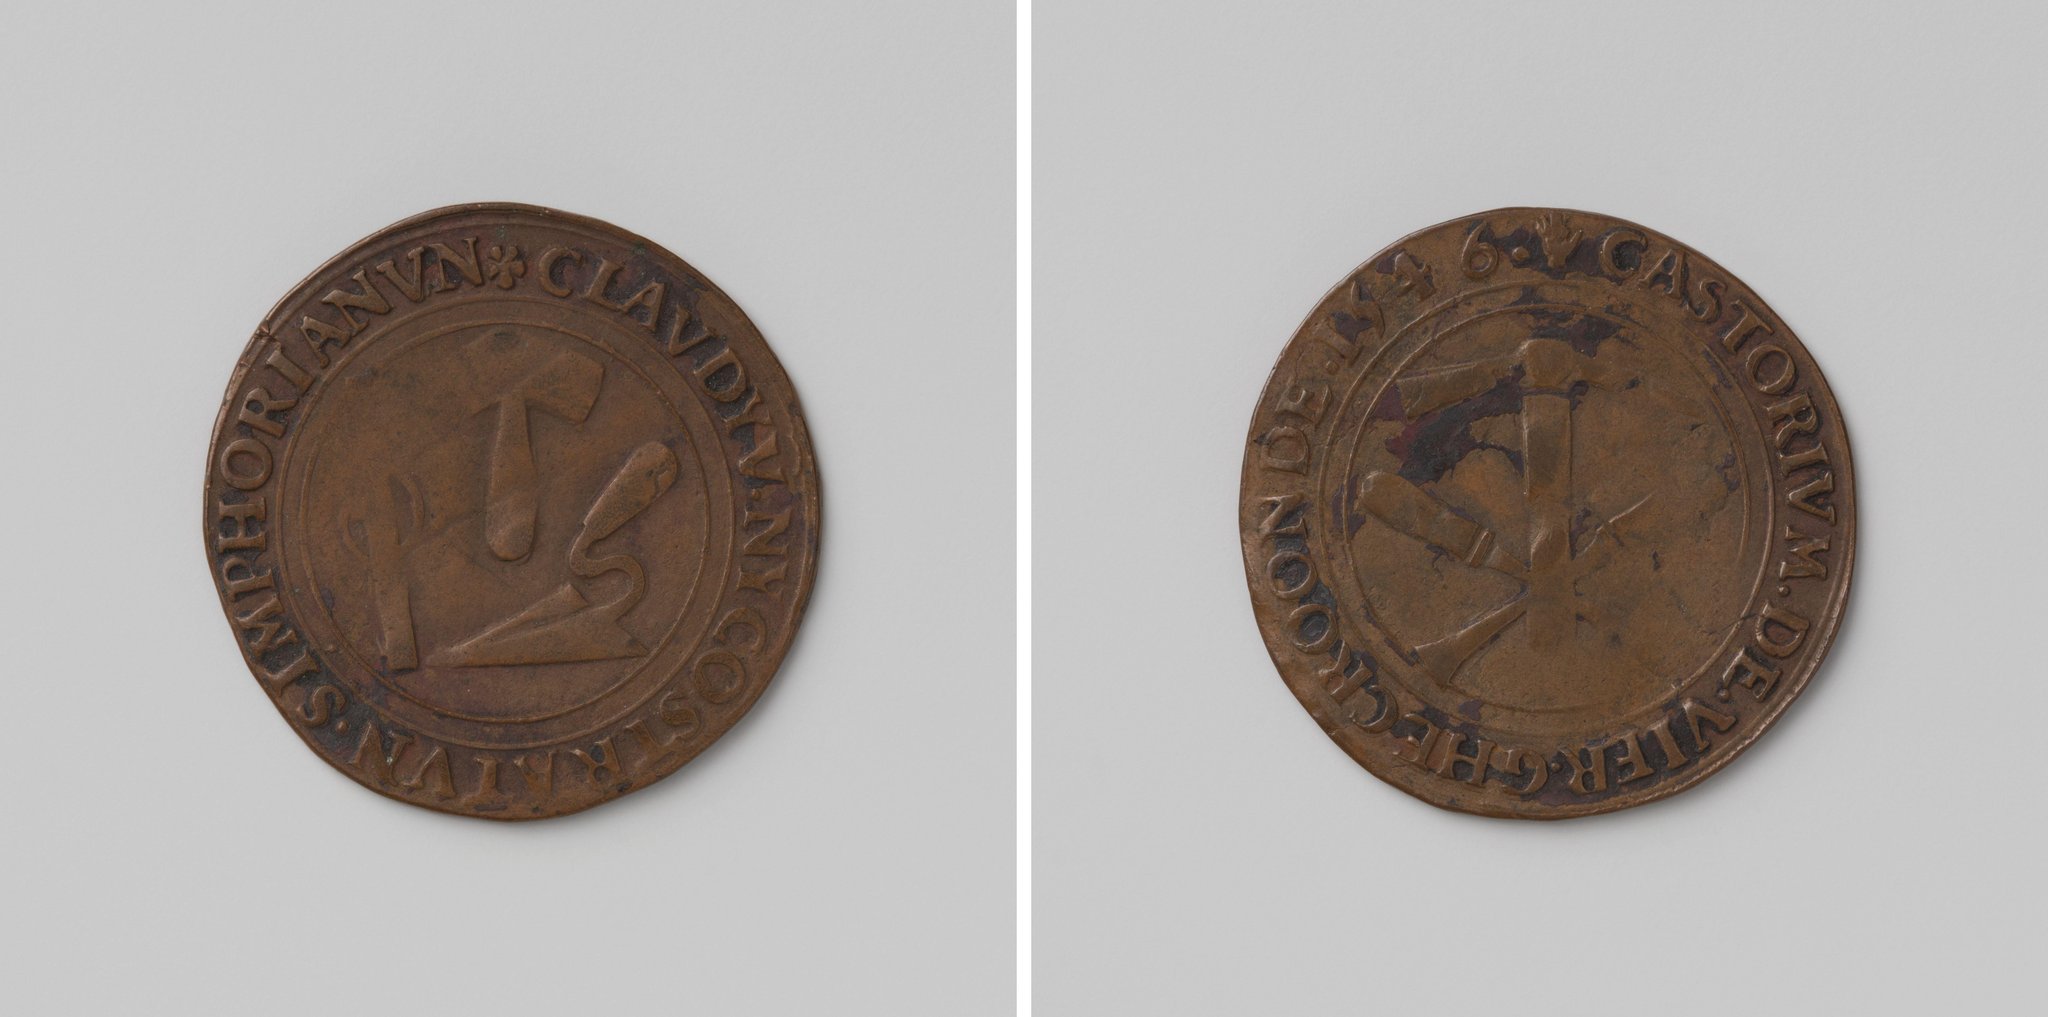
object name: medal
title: Metselaars- en steenhouwersgilde van Antwerpen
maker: Anonymous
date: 1546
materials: copper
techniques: striking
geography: antwerp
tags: antwerp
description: Koperen penning. Voorzijde: hamer, troffel en langwerpig voorwerp binnen omschrift. Keerzijde: hamer voor twee gekruiste beitels binnen omschrift